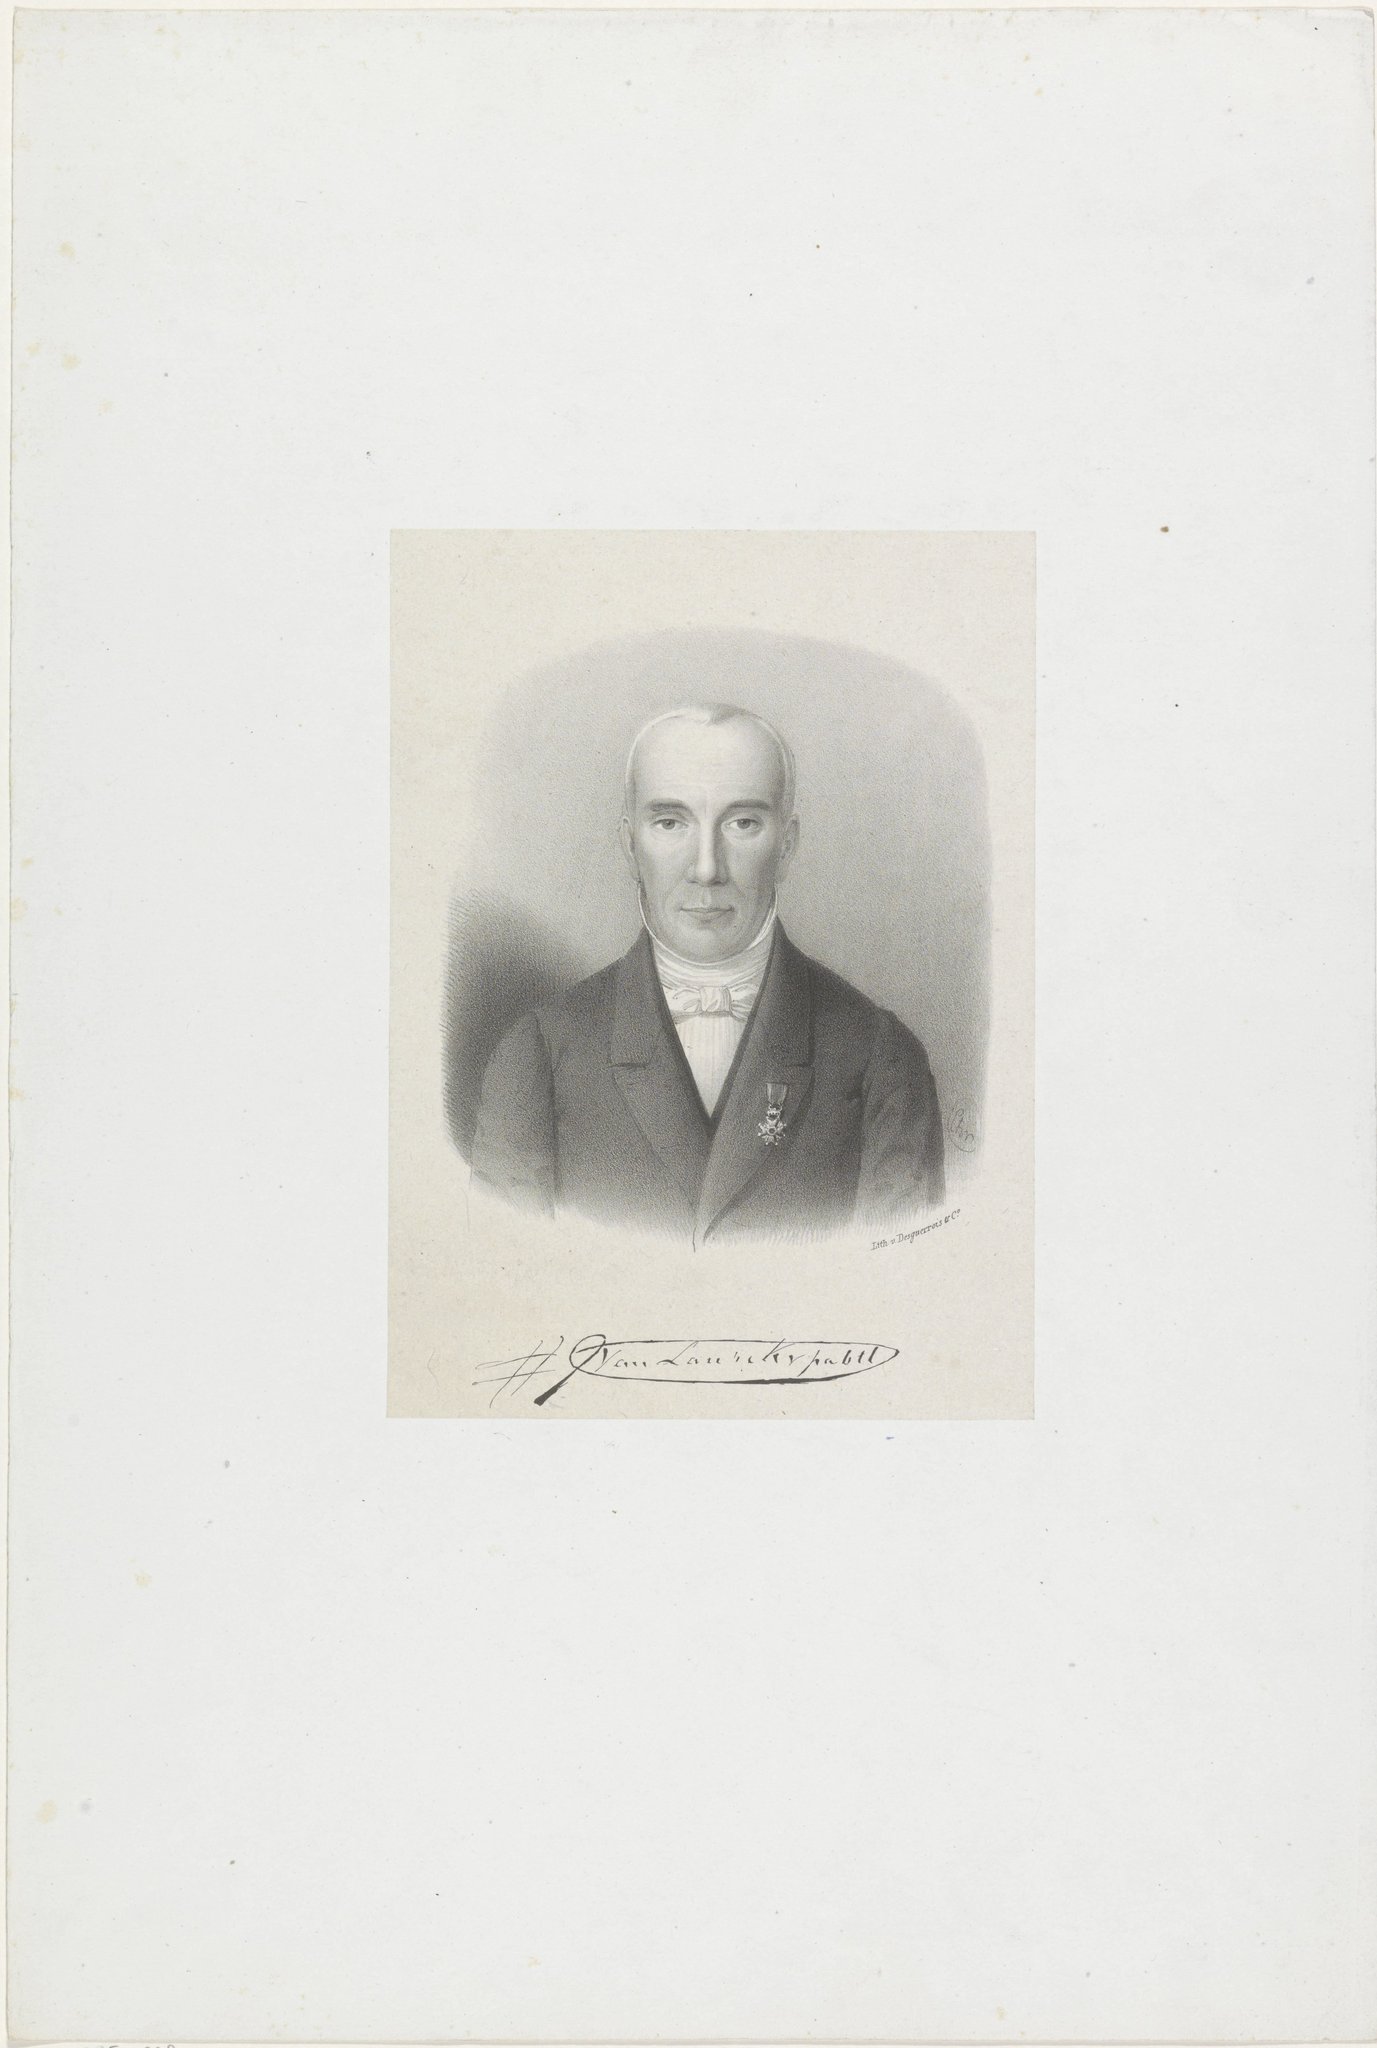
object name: print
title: Portret van Pieter Herbert van Lawick van Pabst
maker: wilhelmus cornelis chimaer van oudendorp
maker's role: print maker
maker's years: 1822-1873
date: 1832-1873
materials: paper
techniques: lithograph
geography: netherlands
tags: official, historical persons (+ head (and shoulders) (portrait)), knighthood order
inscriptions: collector's mark: Lugt 2228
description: De geportretteerde is en face afgebeeld. Op de borst draagt hij het kruis van de ridderorde van de Nederlandse Leeuw. Onder het portret zijn signatuur.